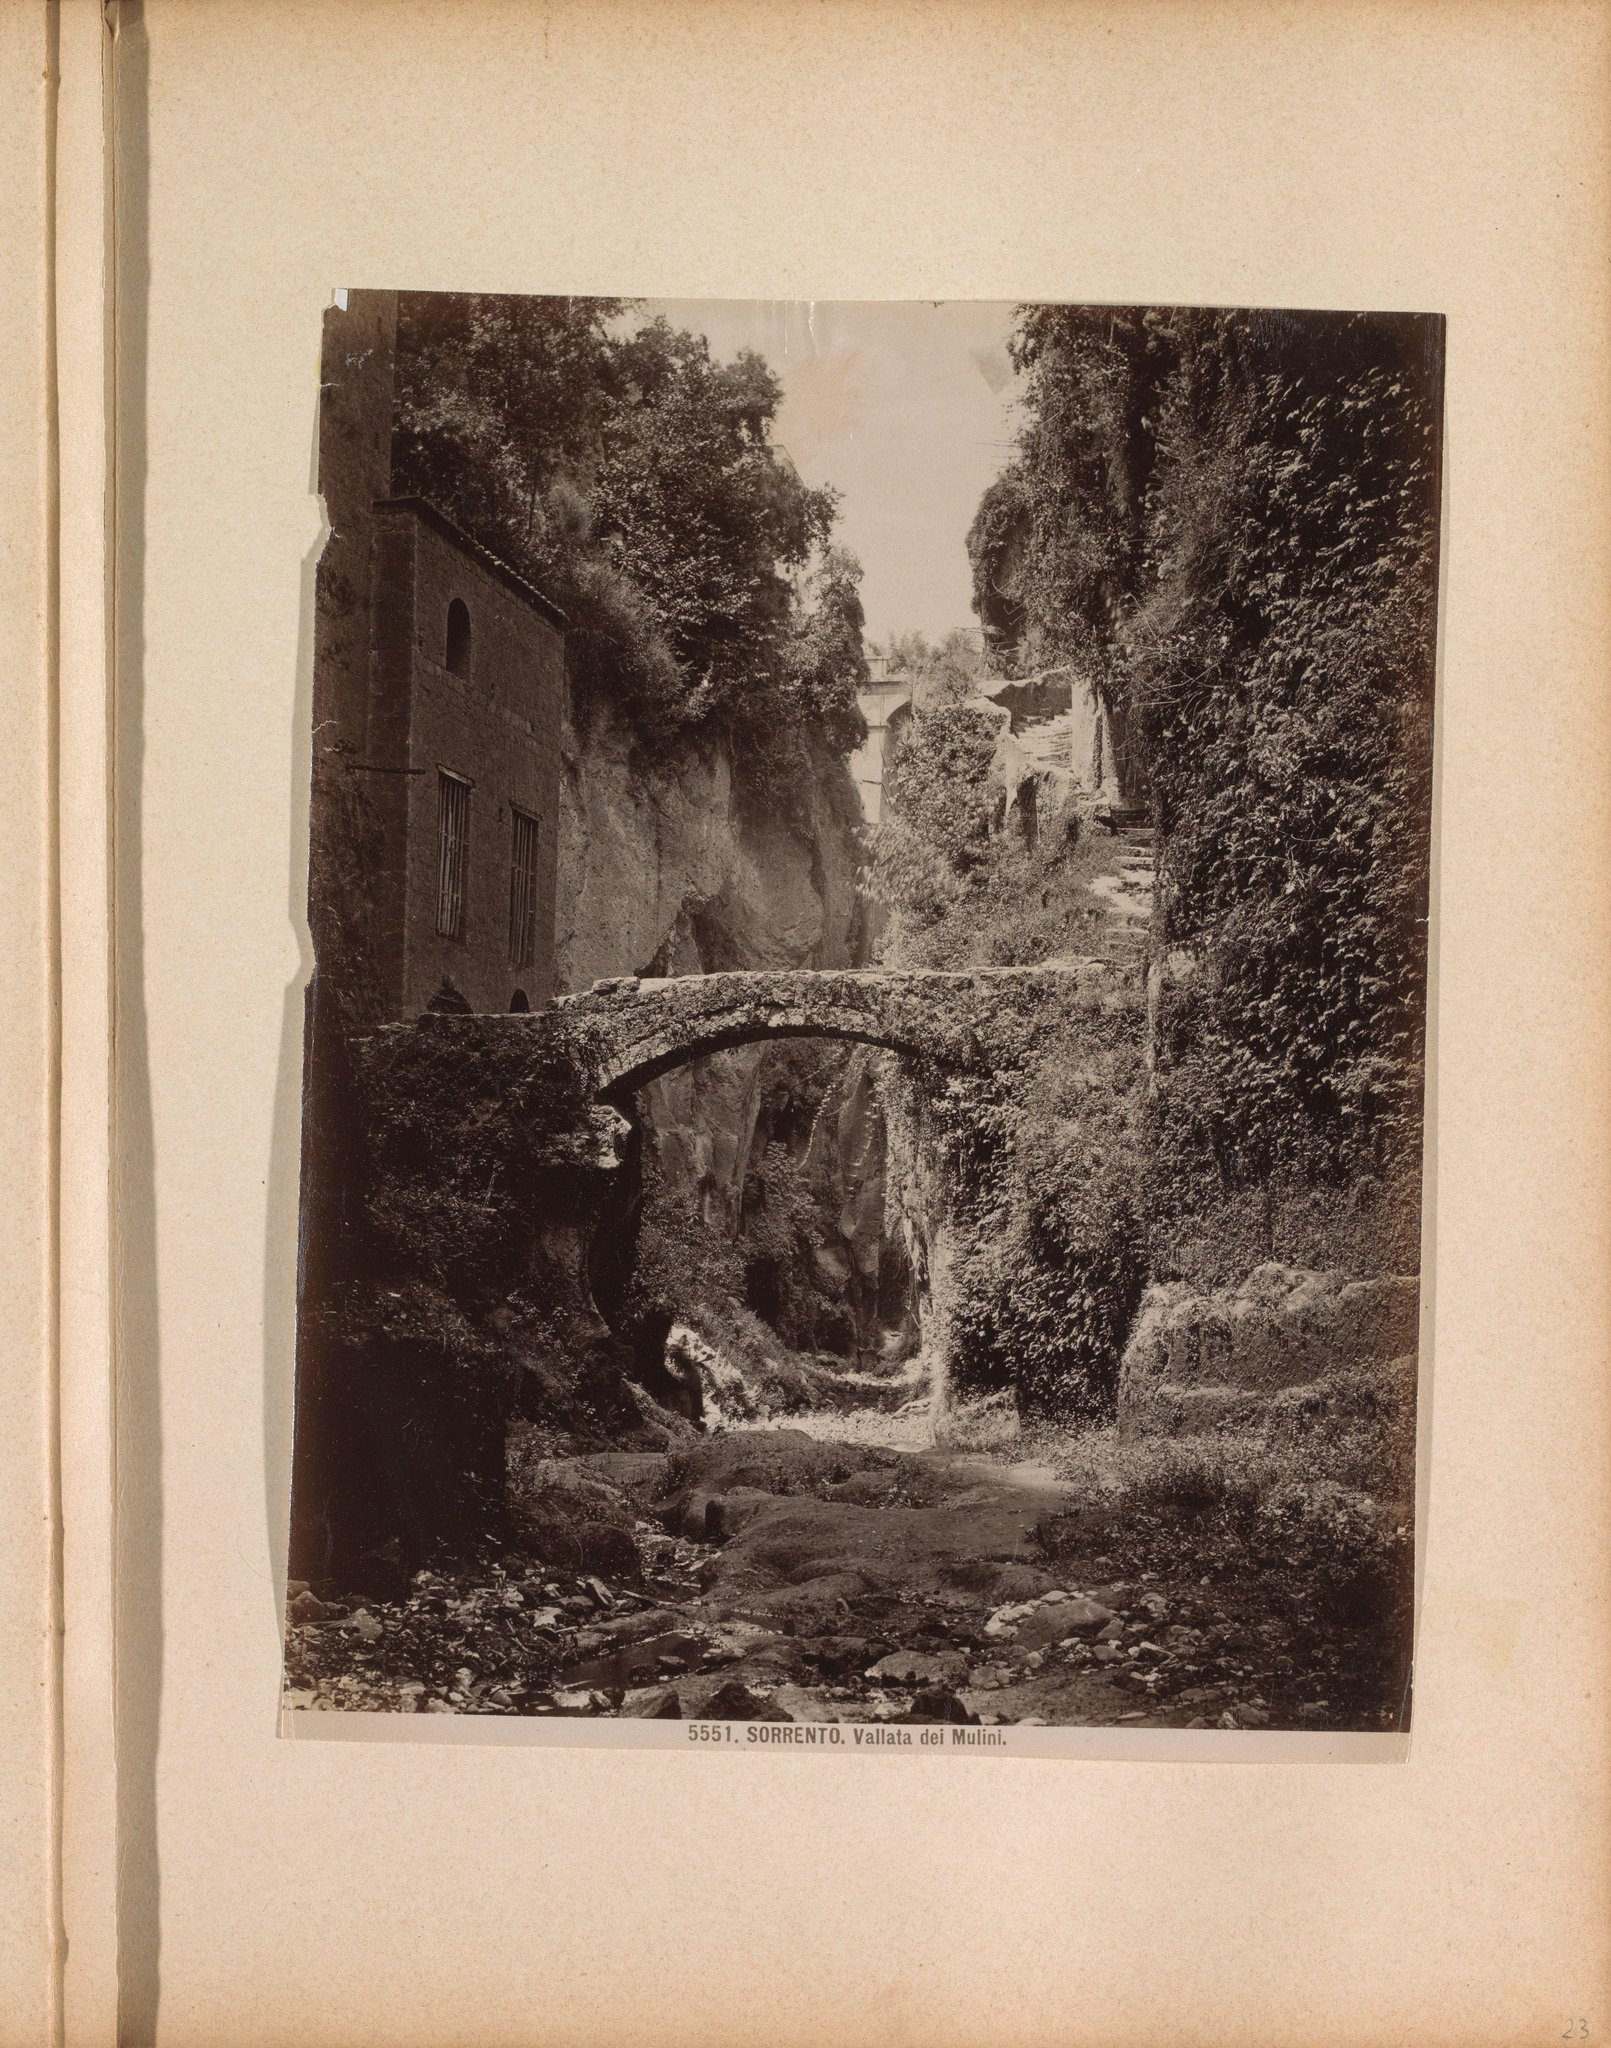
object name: photograph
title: Gezicht op ruïnes in de Vallata dei Mulini te Sorrento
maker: Anonymous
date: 1870-1900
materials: paper, photographic support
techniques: albumen print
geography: sorrento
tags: ruin of a dwelling, house, castle, etc., sorrento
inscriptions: negative number: ‘5551’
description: Onderdeel van Reisalbum met foto's van bezienswaardigheden in Italië en Zuid-Frankrijk.